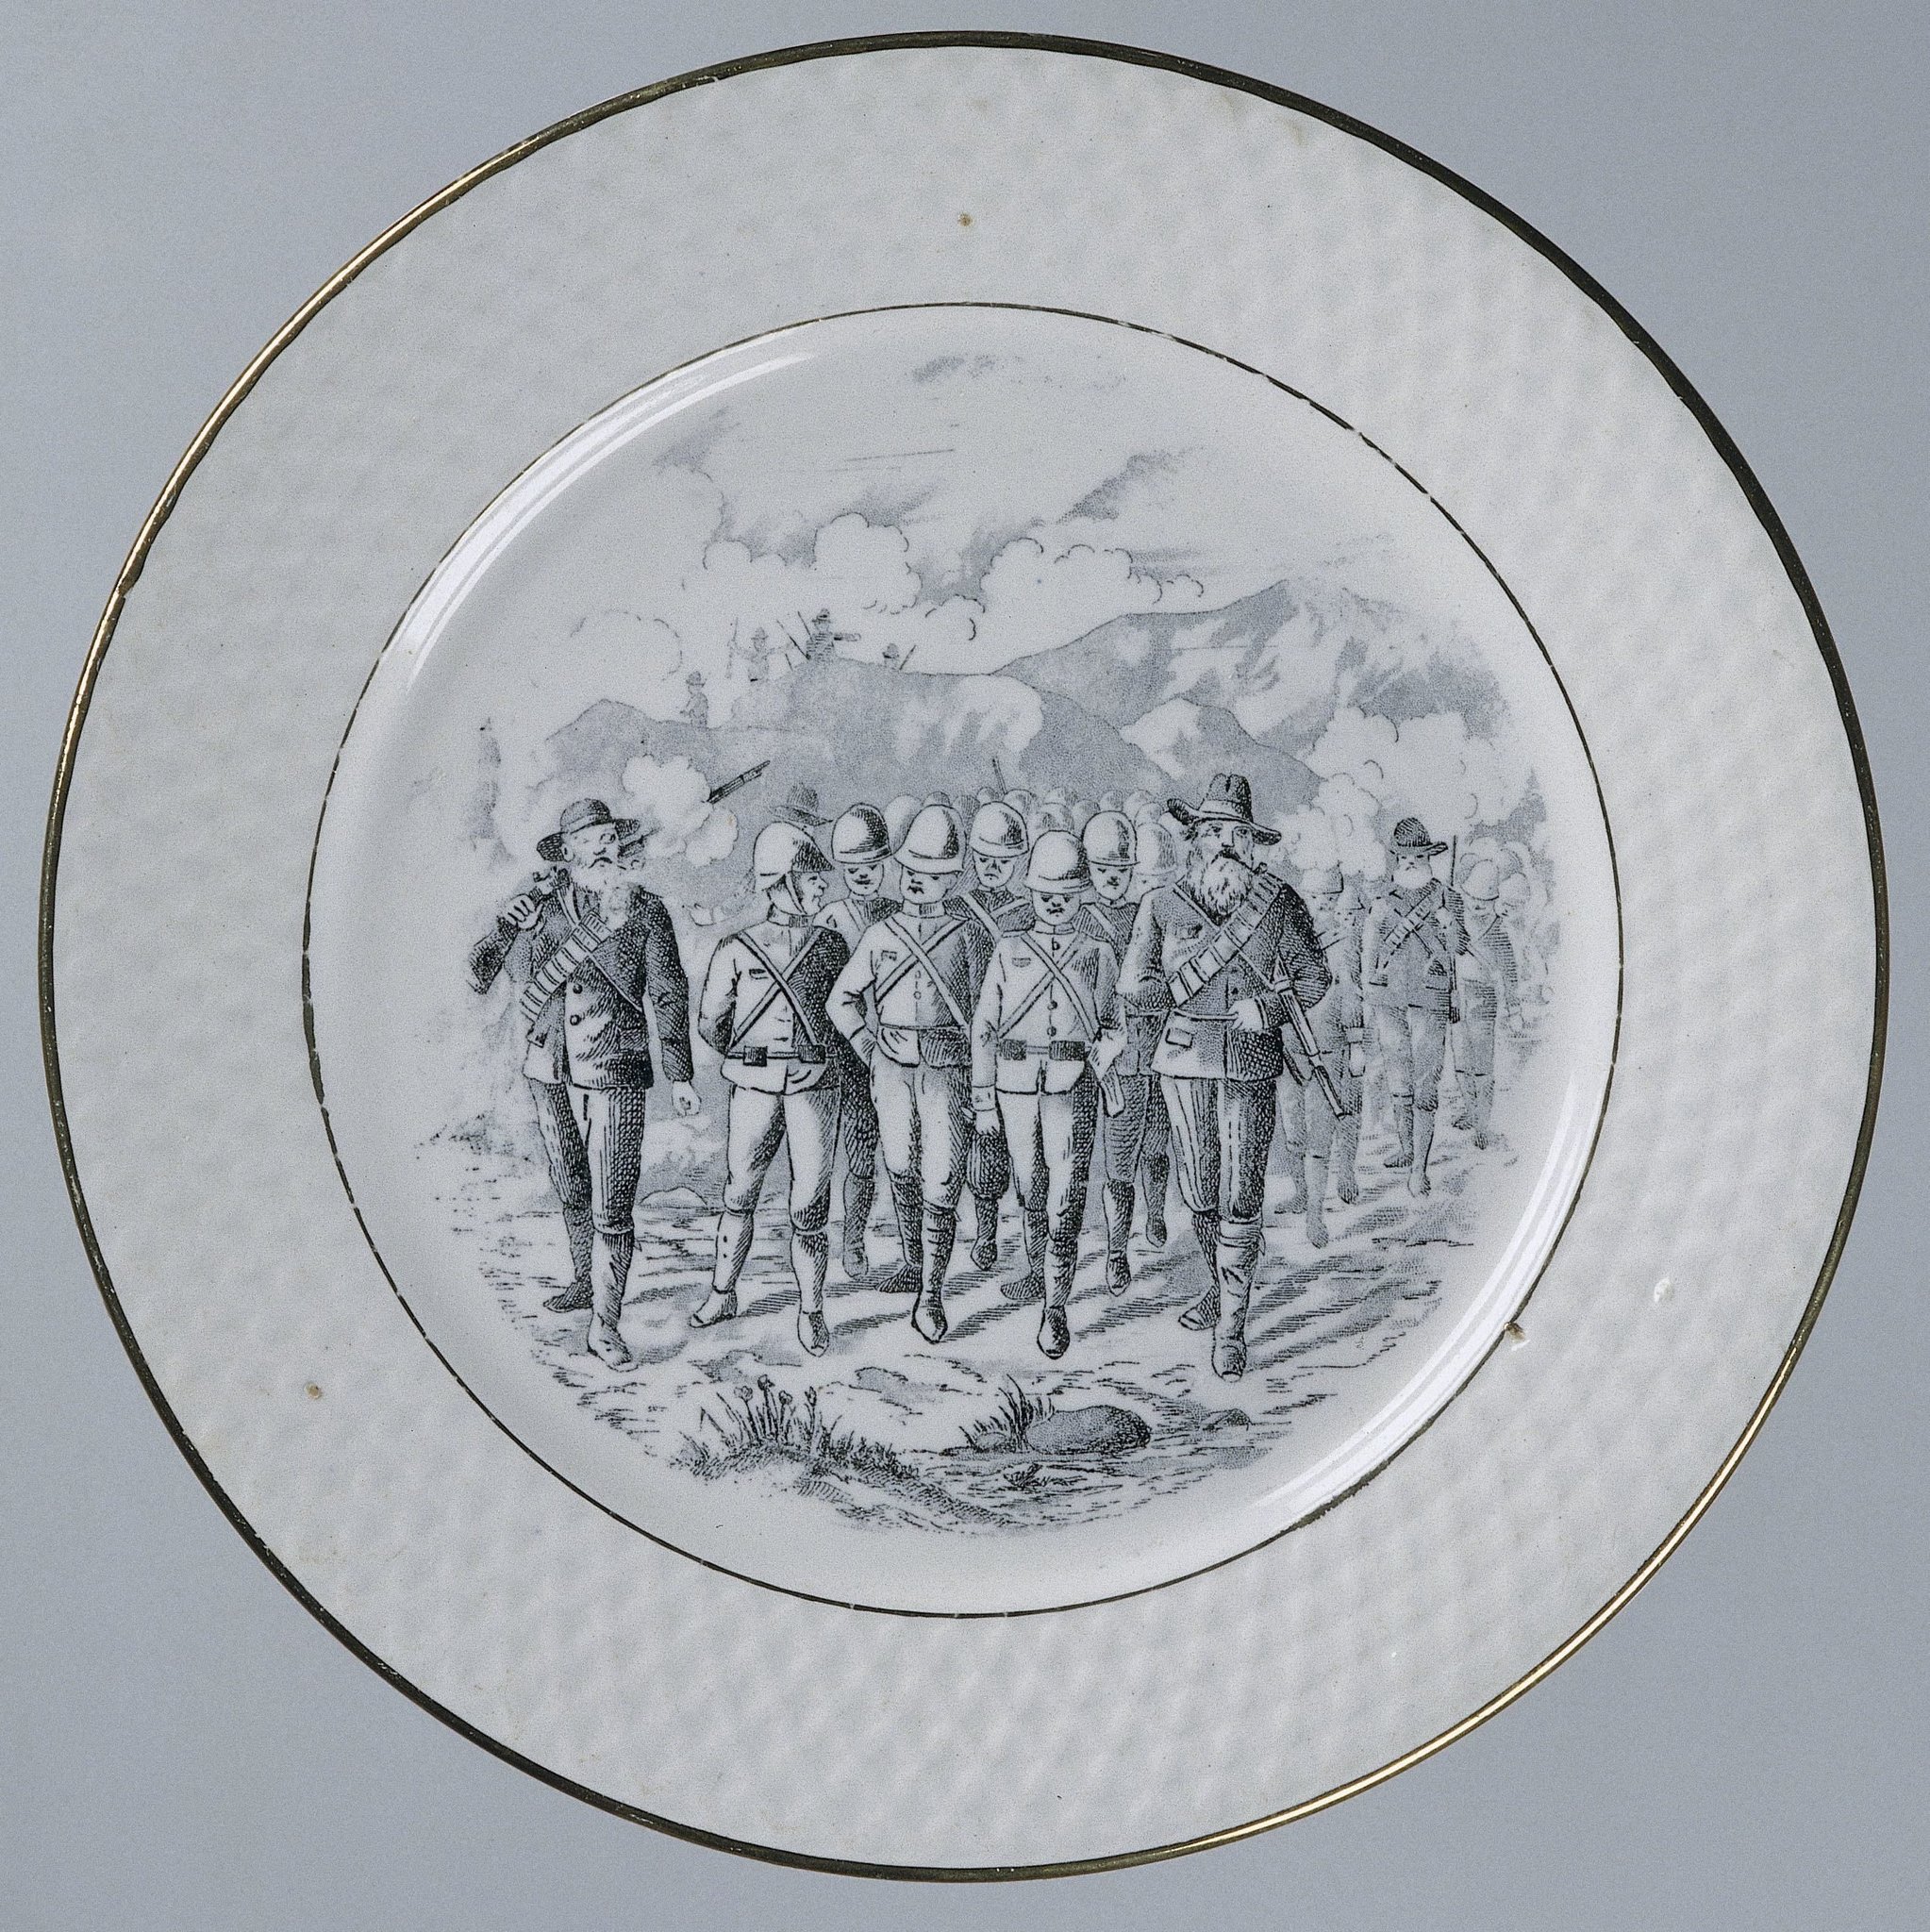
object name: plate dish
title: Herinneringsbord Boerenoorlog: militairen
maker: Anonymous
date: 1899-1925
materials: earthenware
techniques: firing, printing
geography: south africa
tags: troop movements, transportation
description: Commemorative plates with scenes from the Boer War. Earthenware, c. 1910. Made by Petrus Regout, Maastricht. Sympathy for the Boers was so strong in Holland that the memory of the war continued to live on for many years. Particularly popular were the various Afrikaner songs, as well as plates such as these.